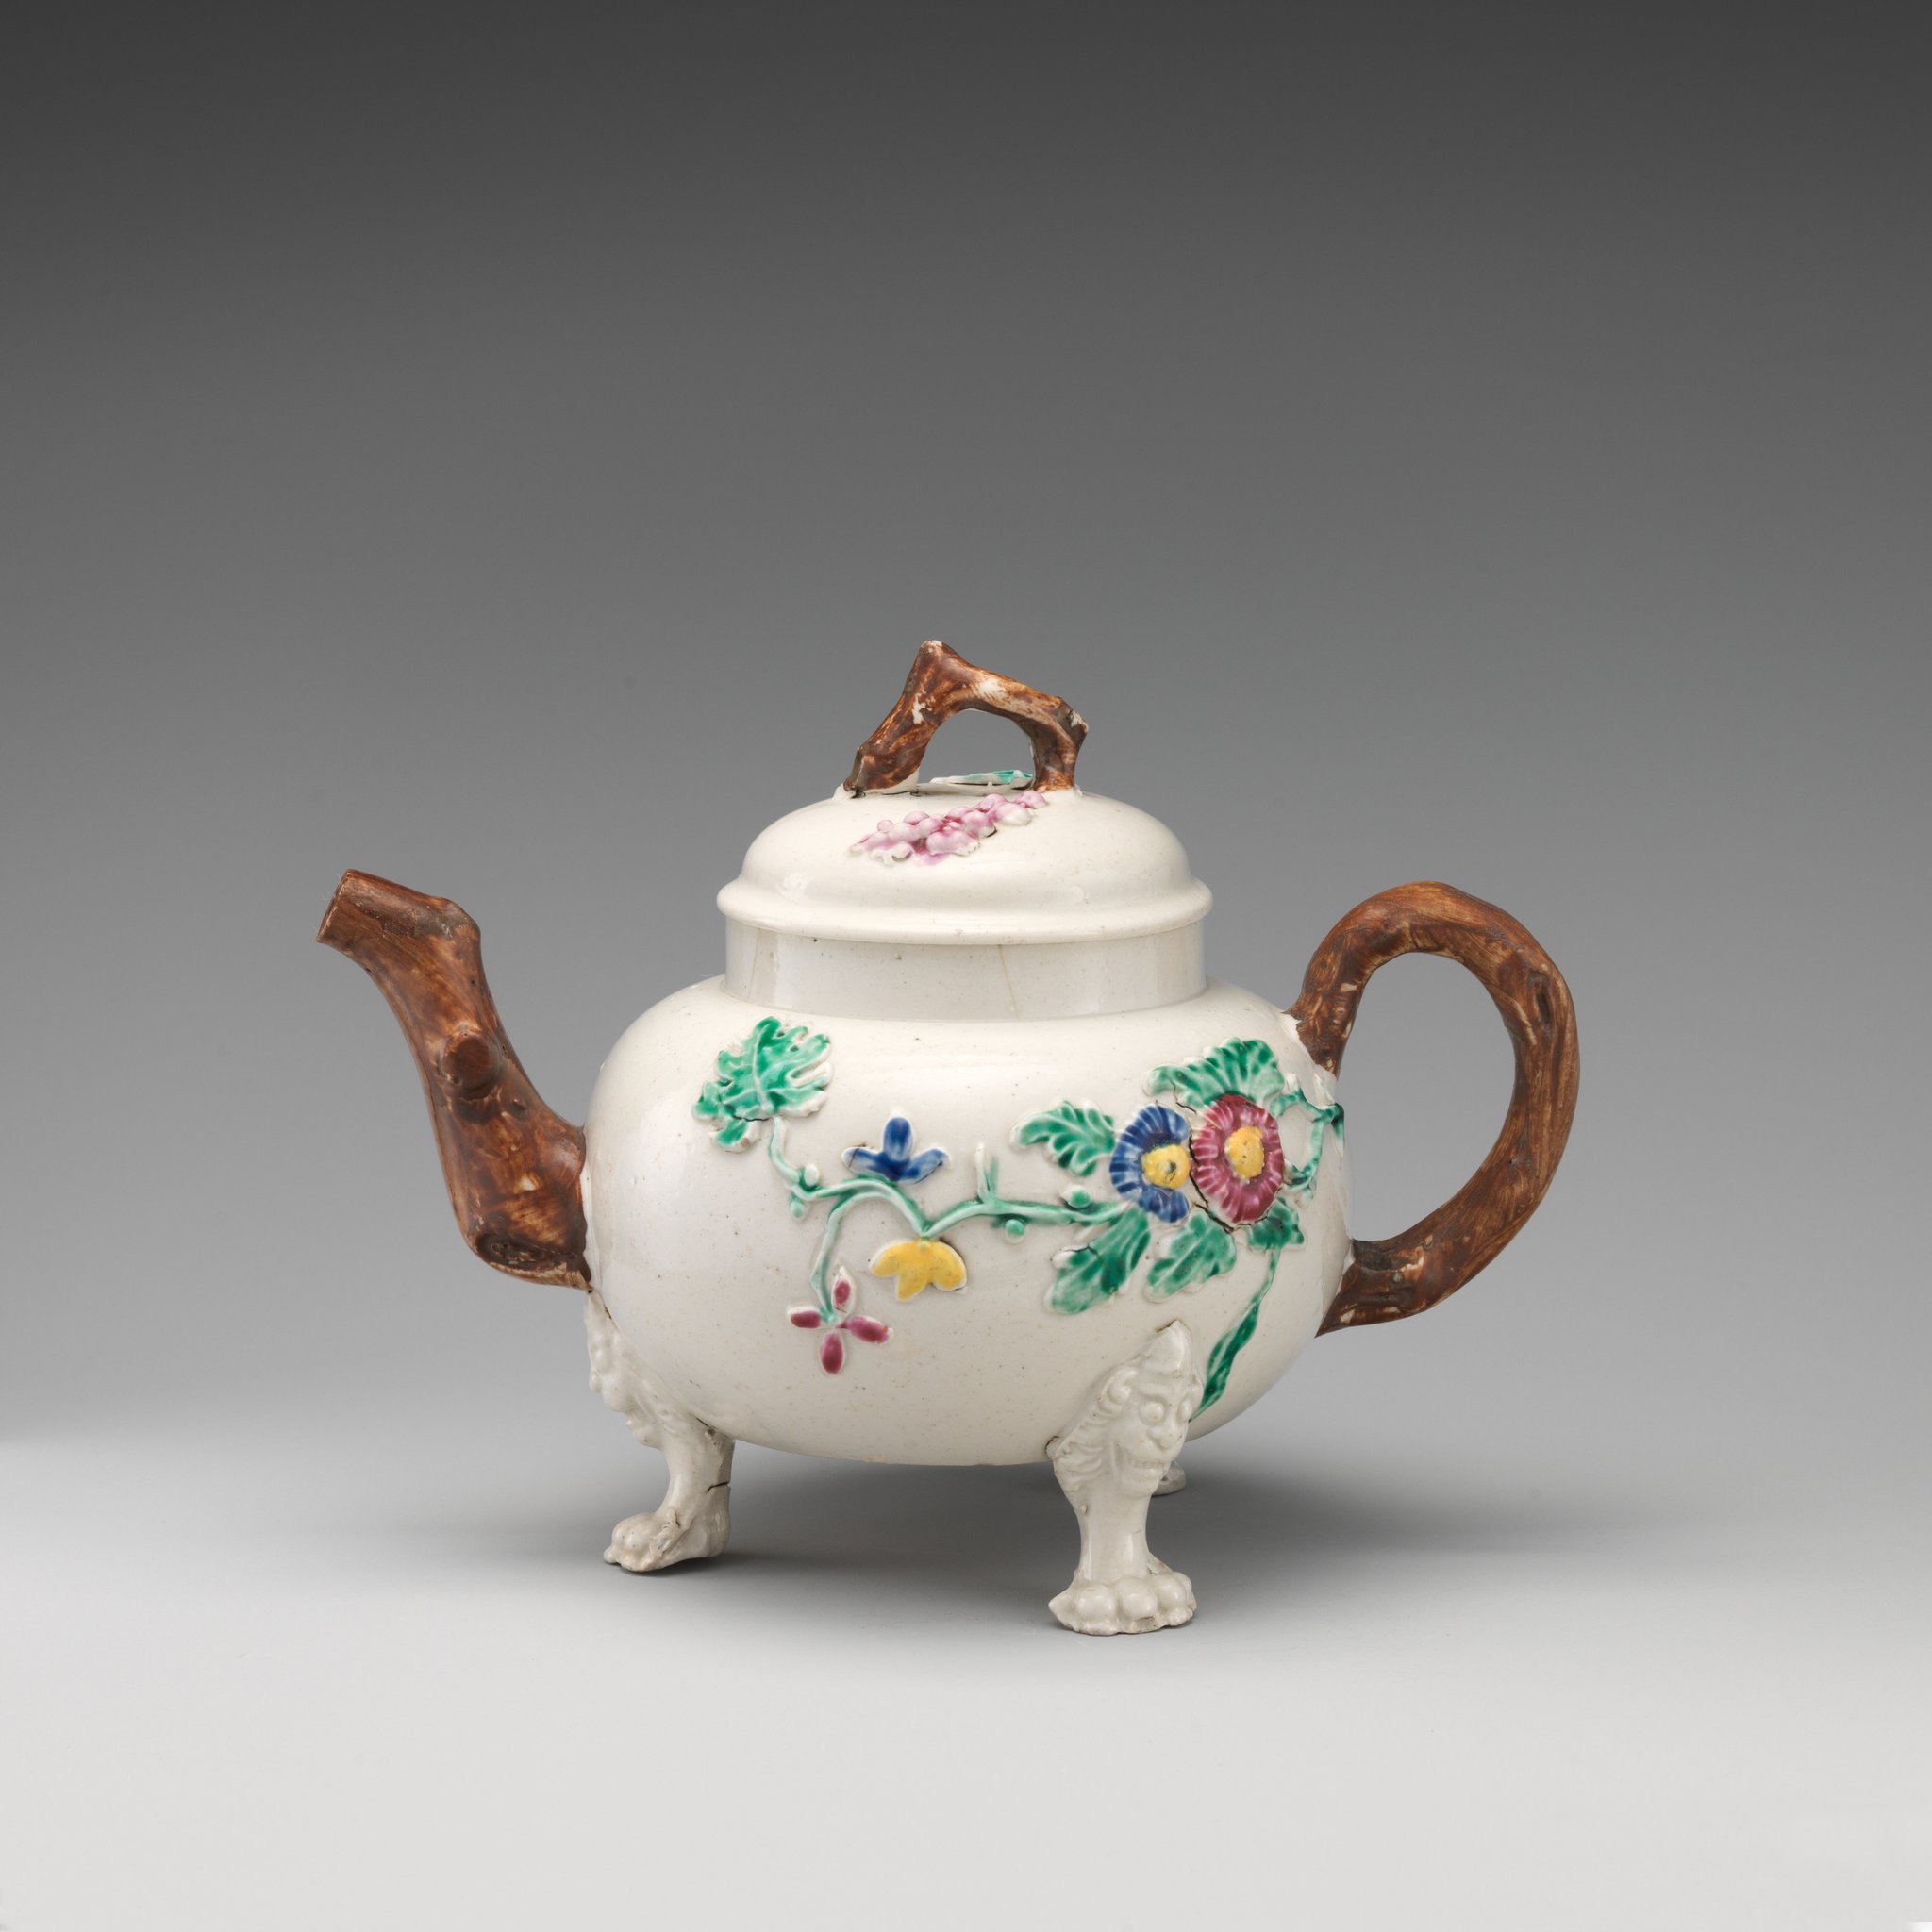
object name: teapot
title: Footed teapot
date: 1755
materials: enamel, stoneware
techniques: salt glaze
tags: flowers